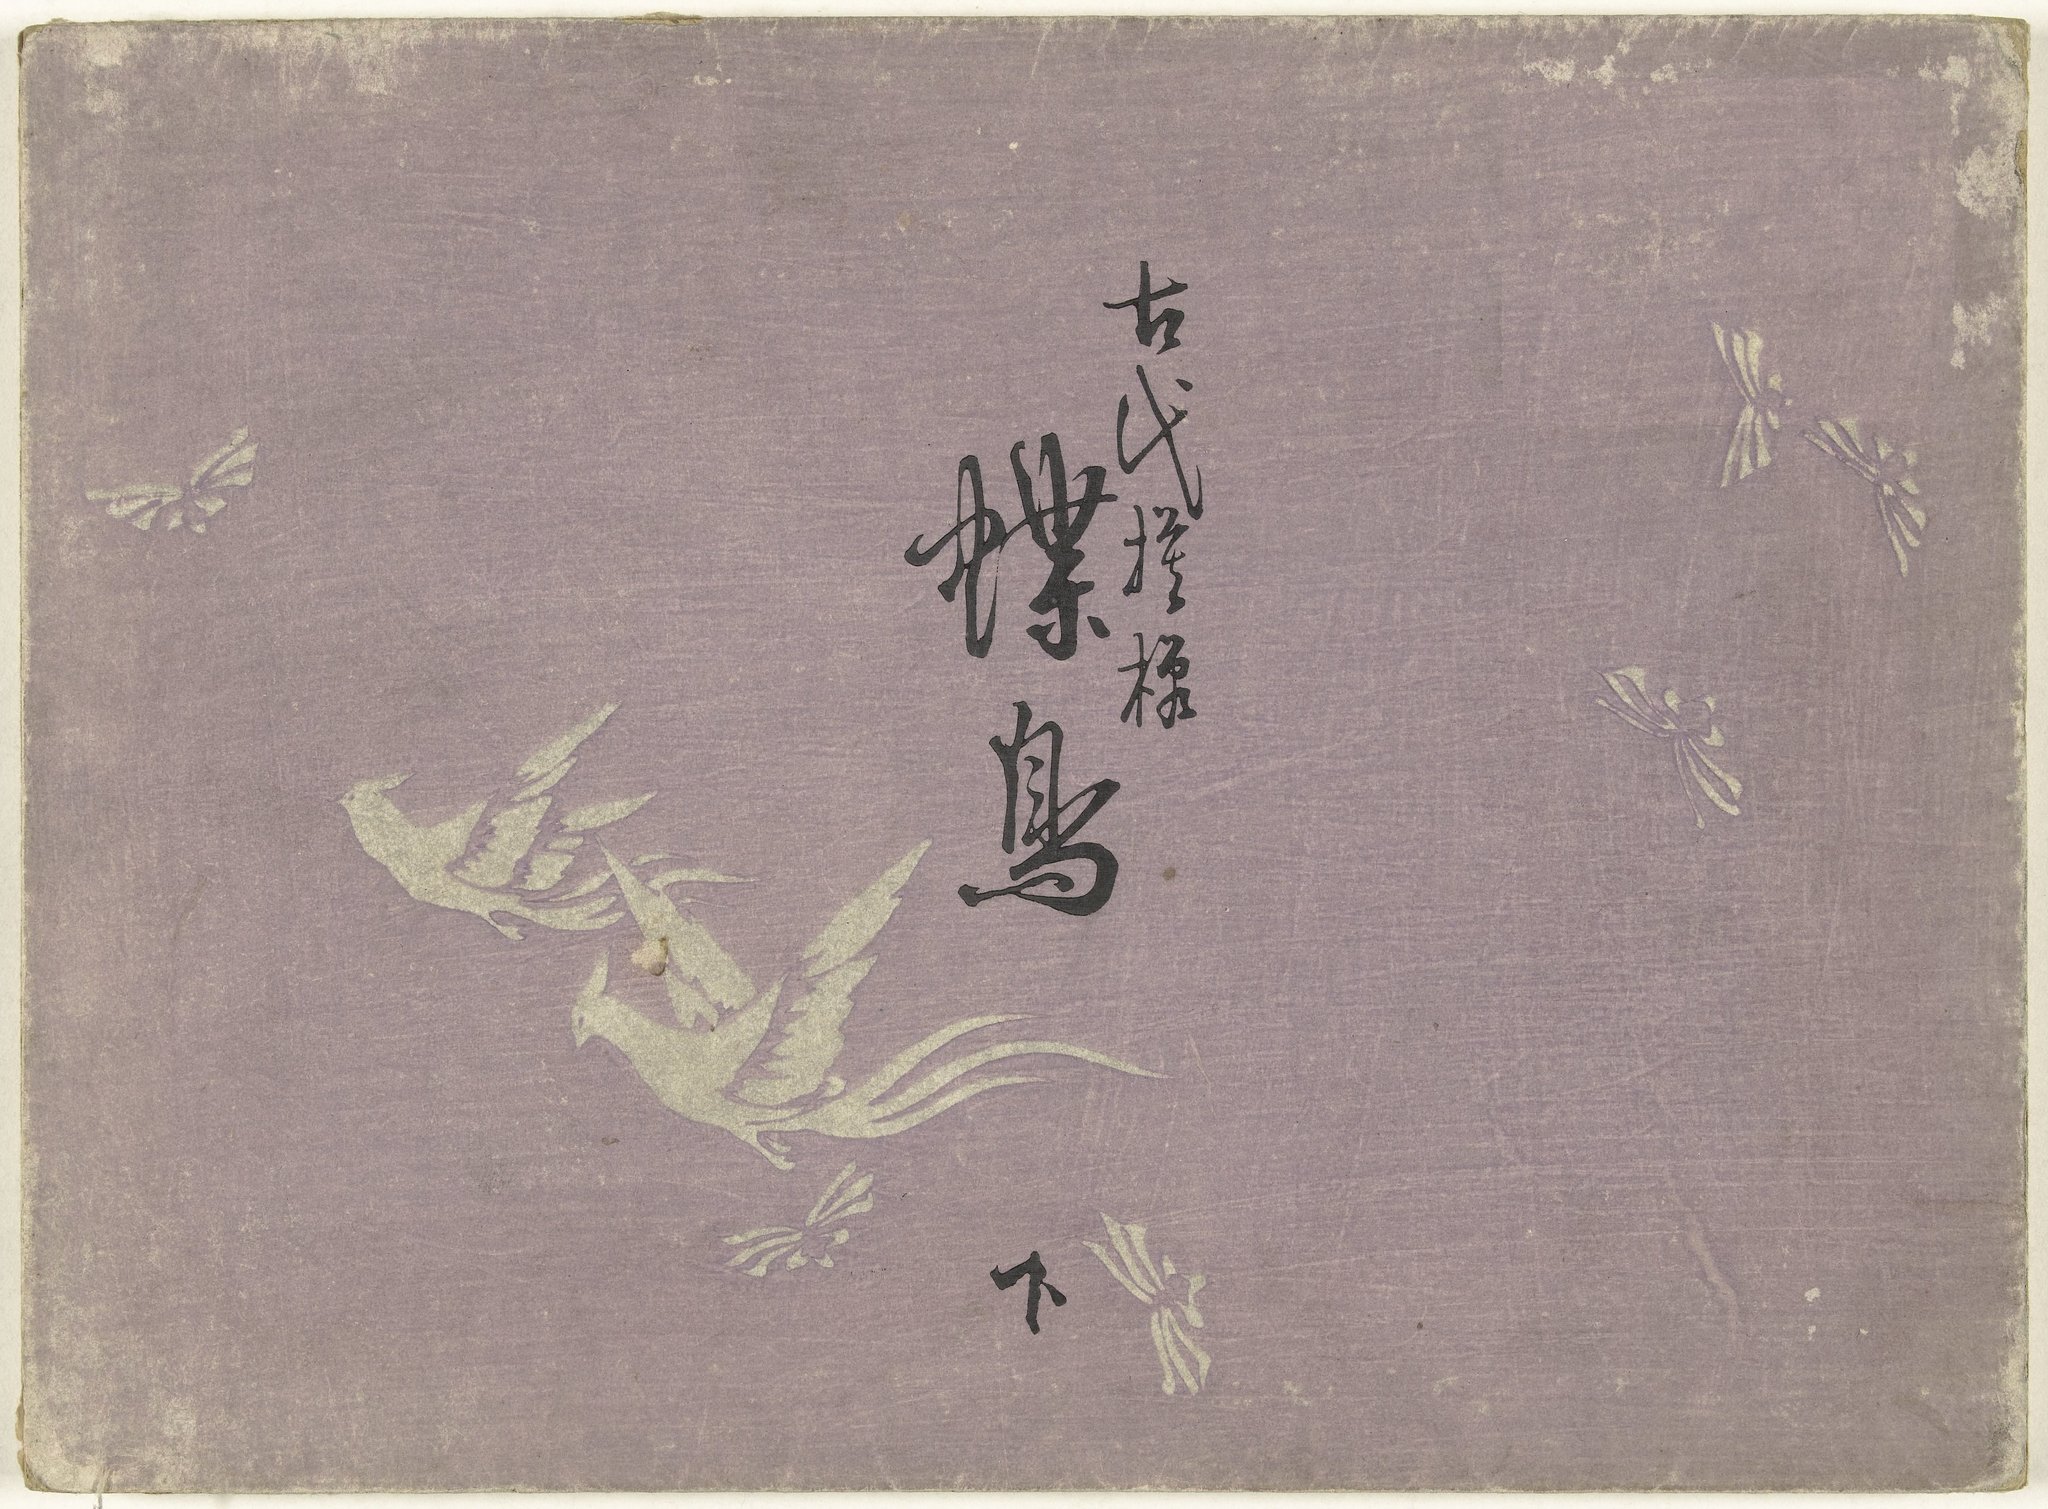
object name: book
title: Vogels en vlinders- deel twee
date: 1905-1906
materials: paper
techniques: woodcut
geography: kyoto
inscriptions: date